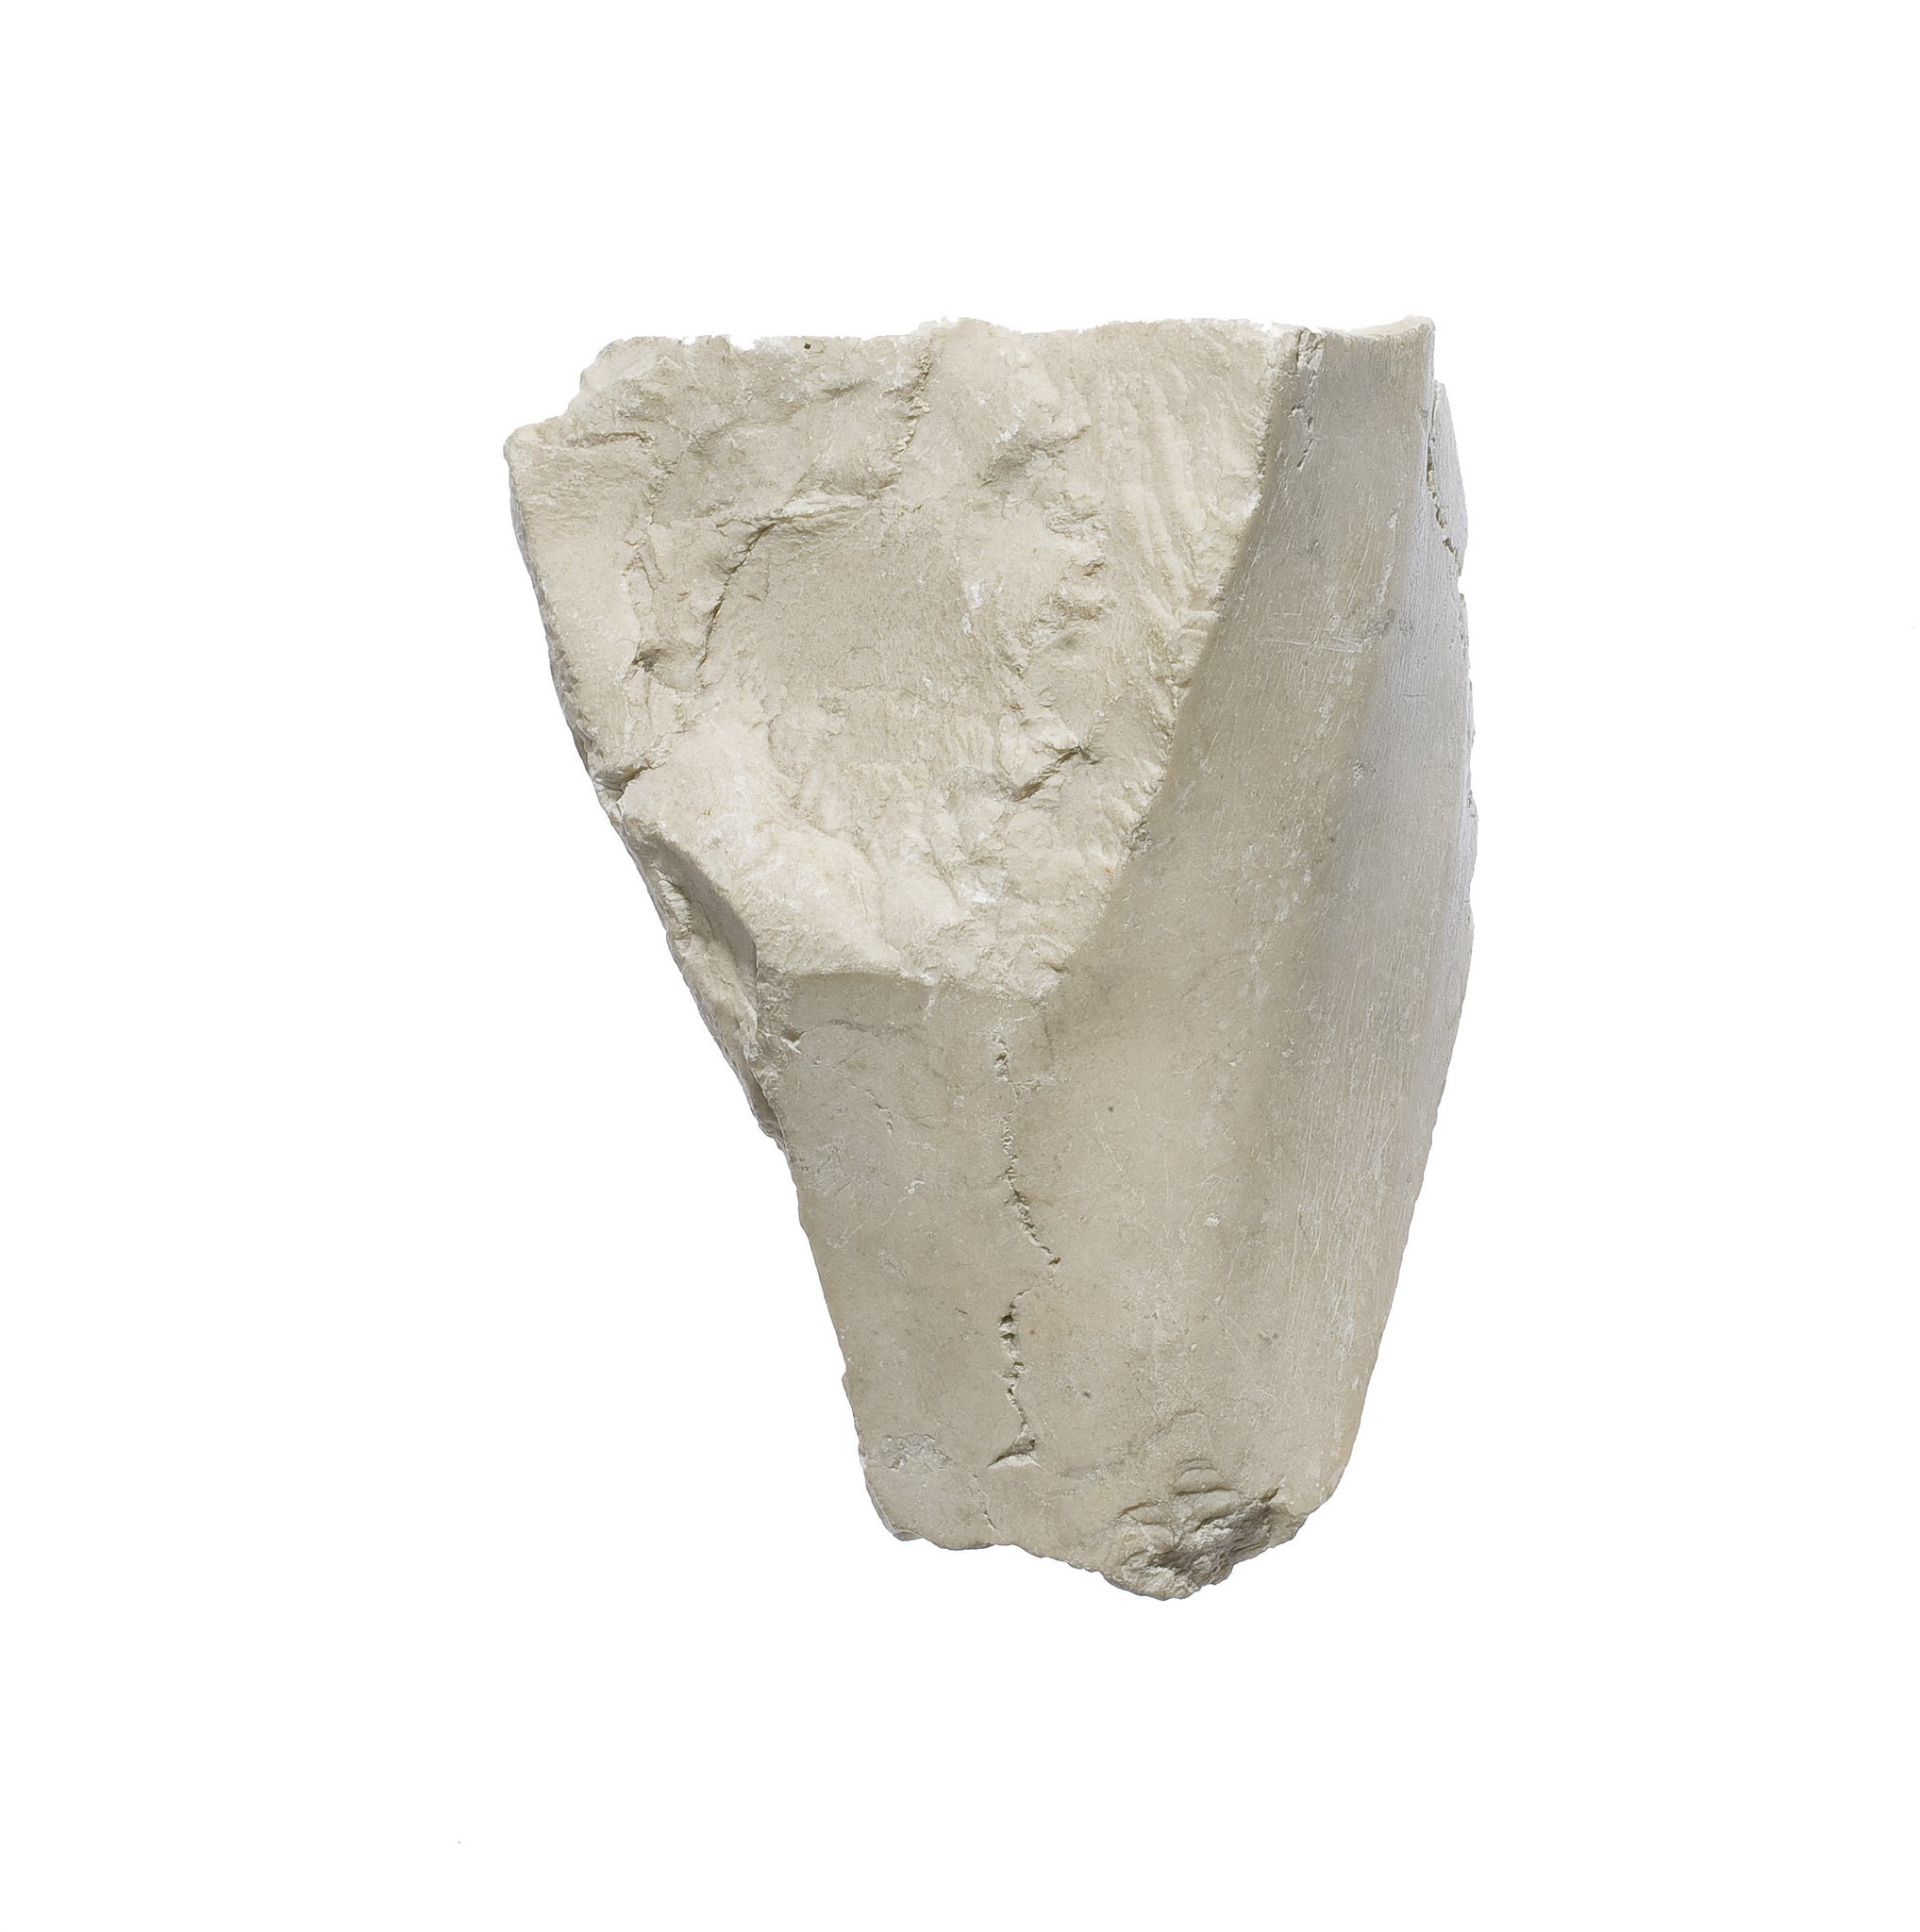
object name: knee with garment, pleat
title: Knee with garment, pleats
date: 1353-1336 BCE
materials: limestone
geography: egypt